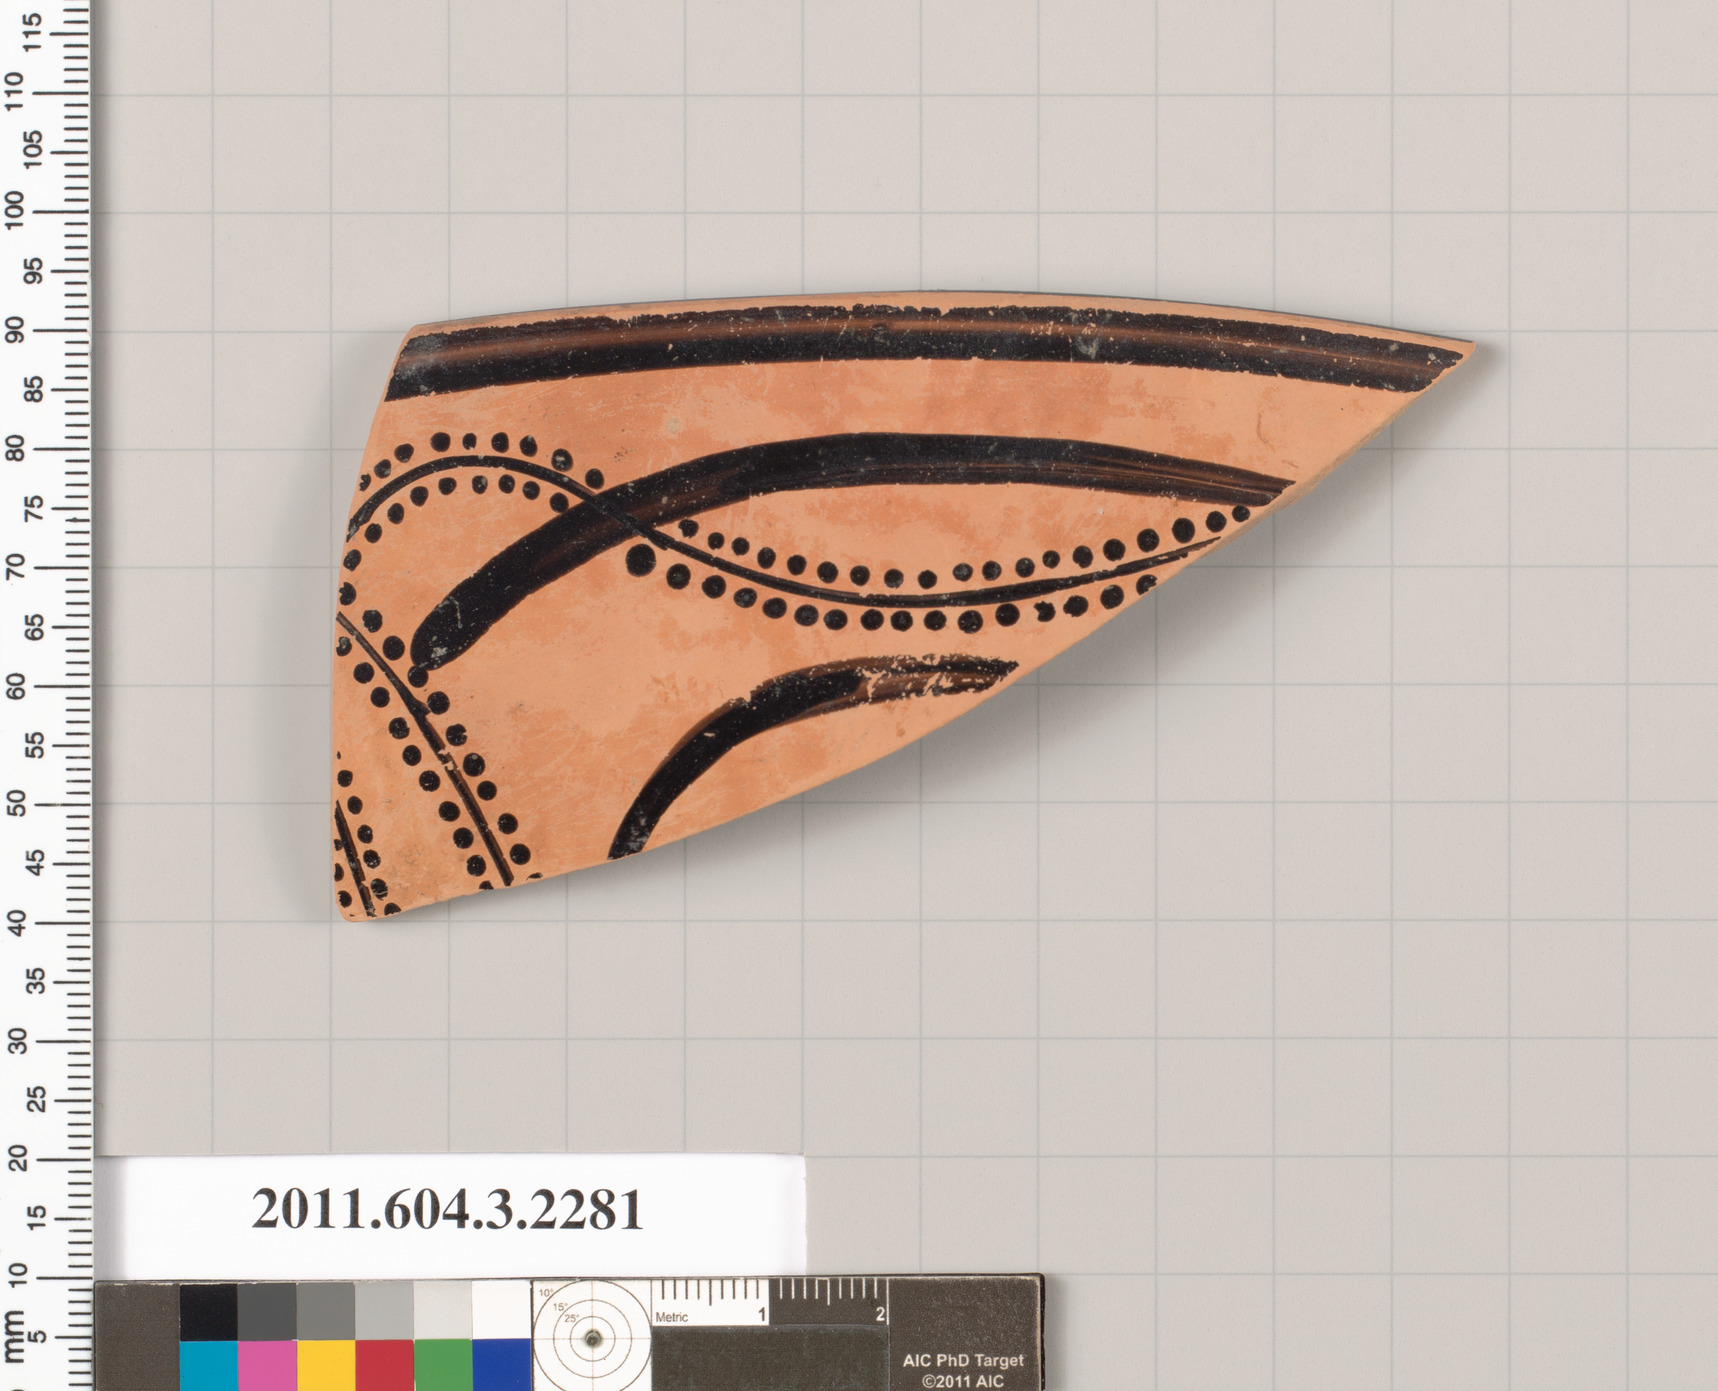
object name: kylix fragment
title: Terracotta rim fragment of a kylix: eye-cup (drinking cup)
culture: greek, attic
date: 540-520 BCE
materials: terracotta